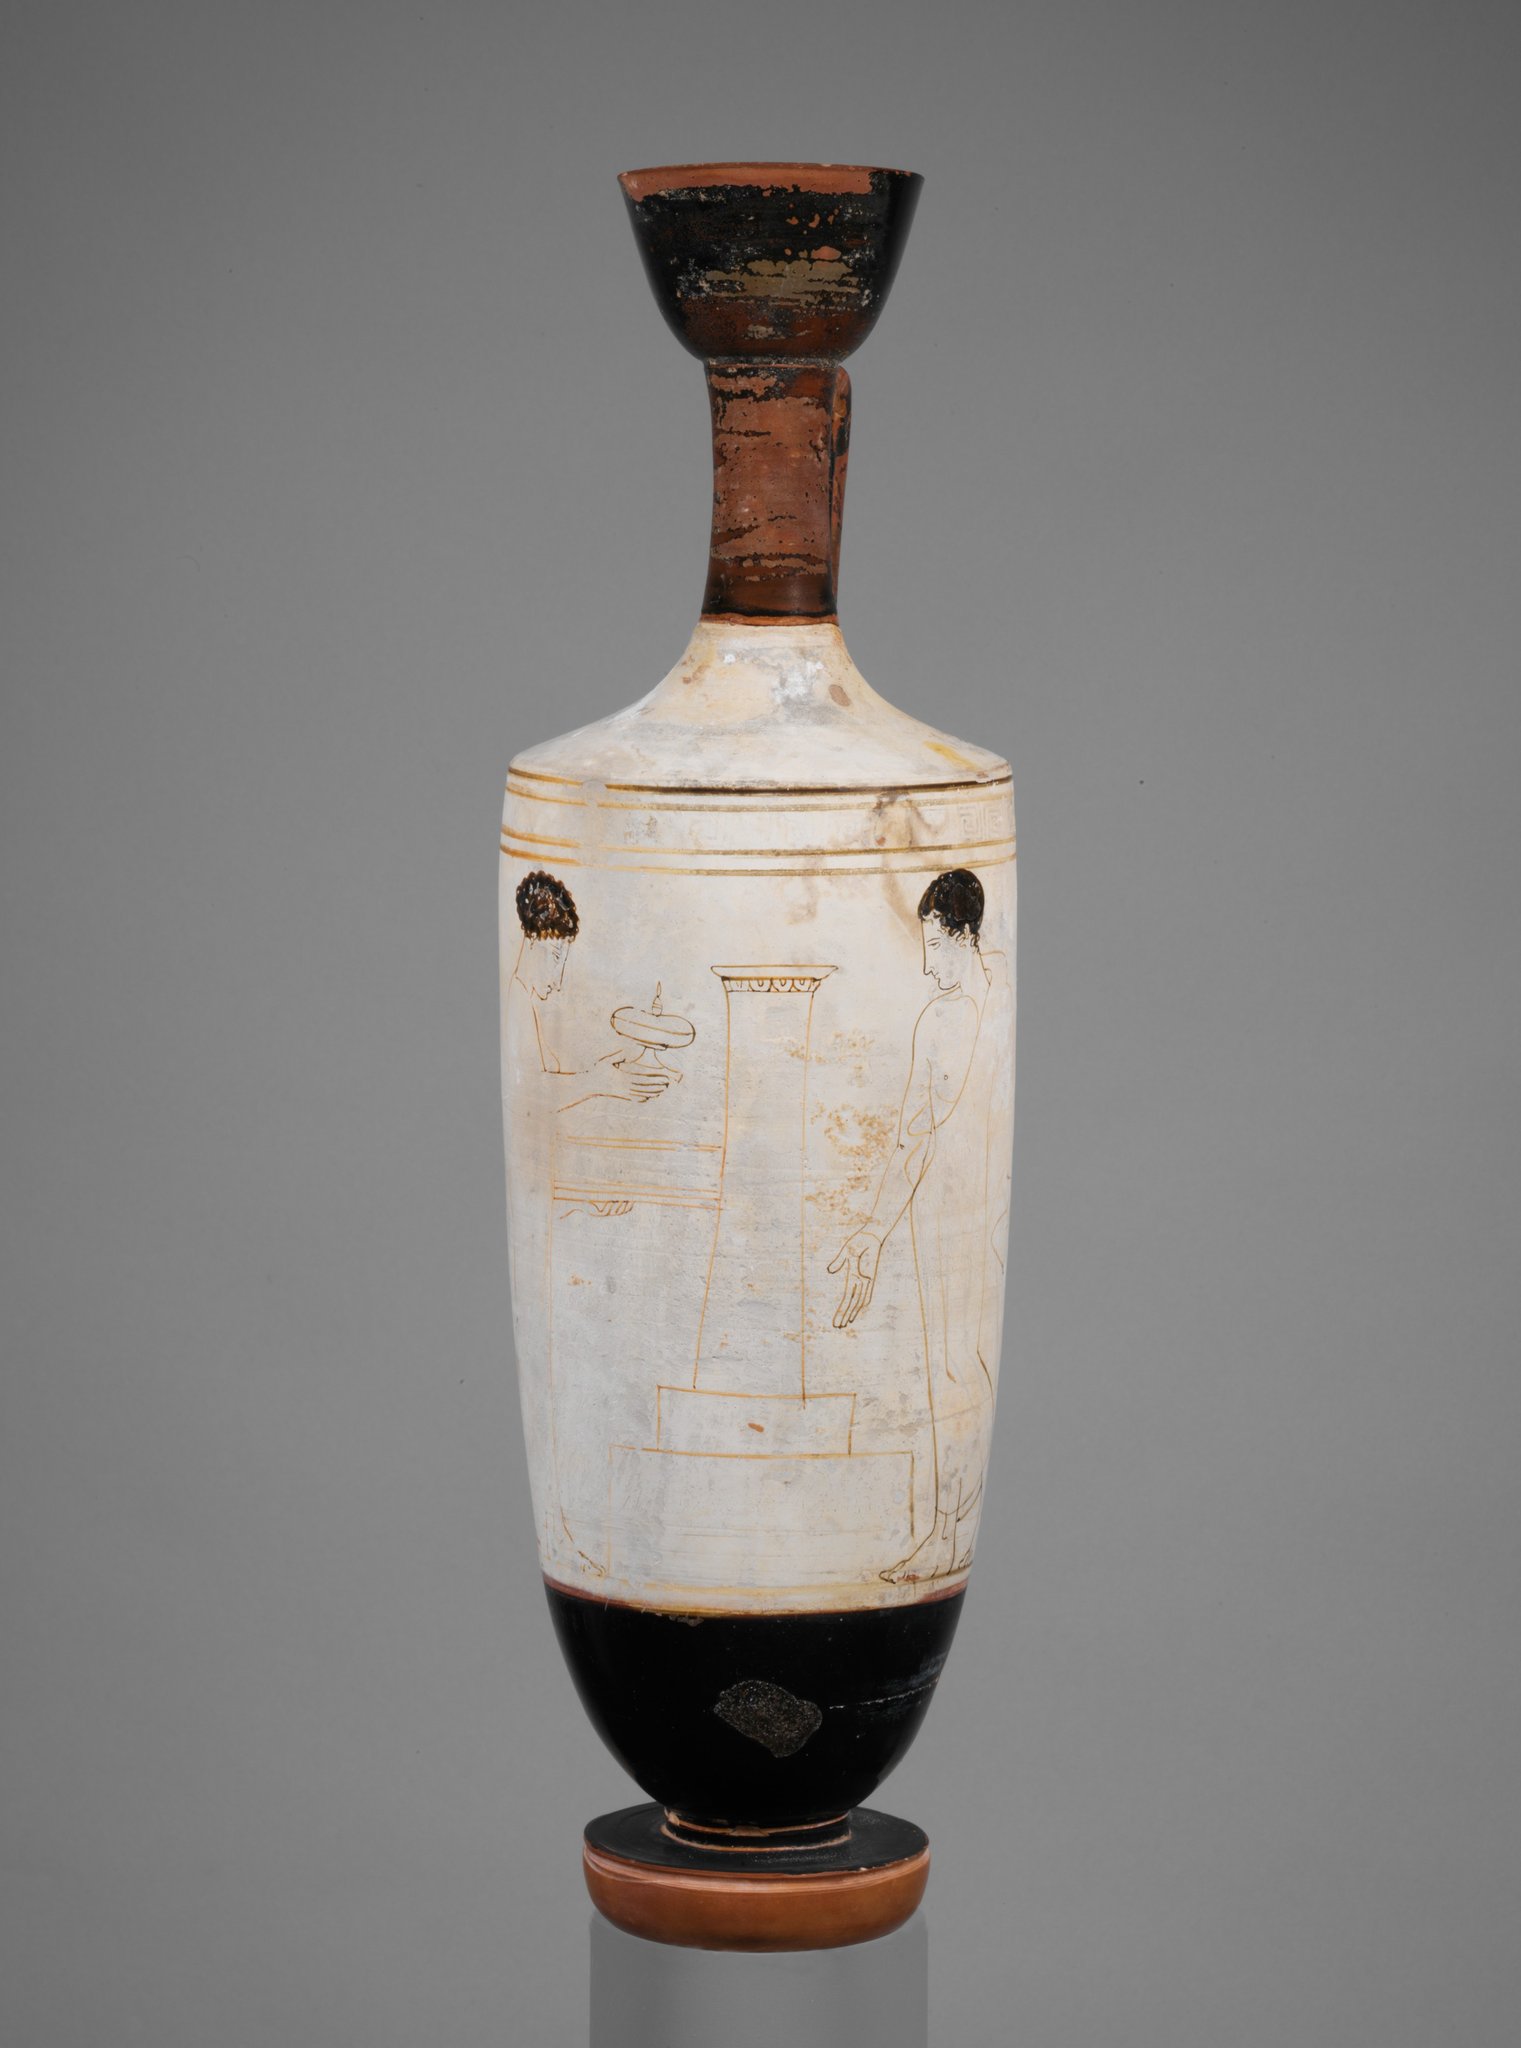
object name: lekythos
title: Terracotta lekythos (oil flask)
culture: greek, attic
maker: painter of new york 23.160.41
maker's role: artist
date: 420 BCE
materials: terracotta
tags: men,women